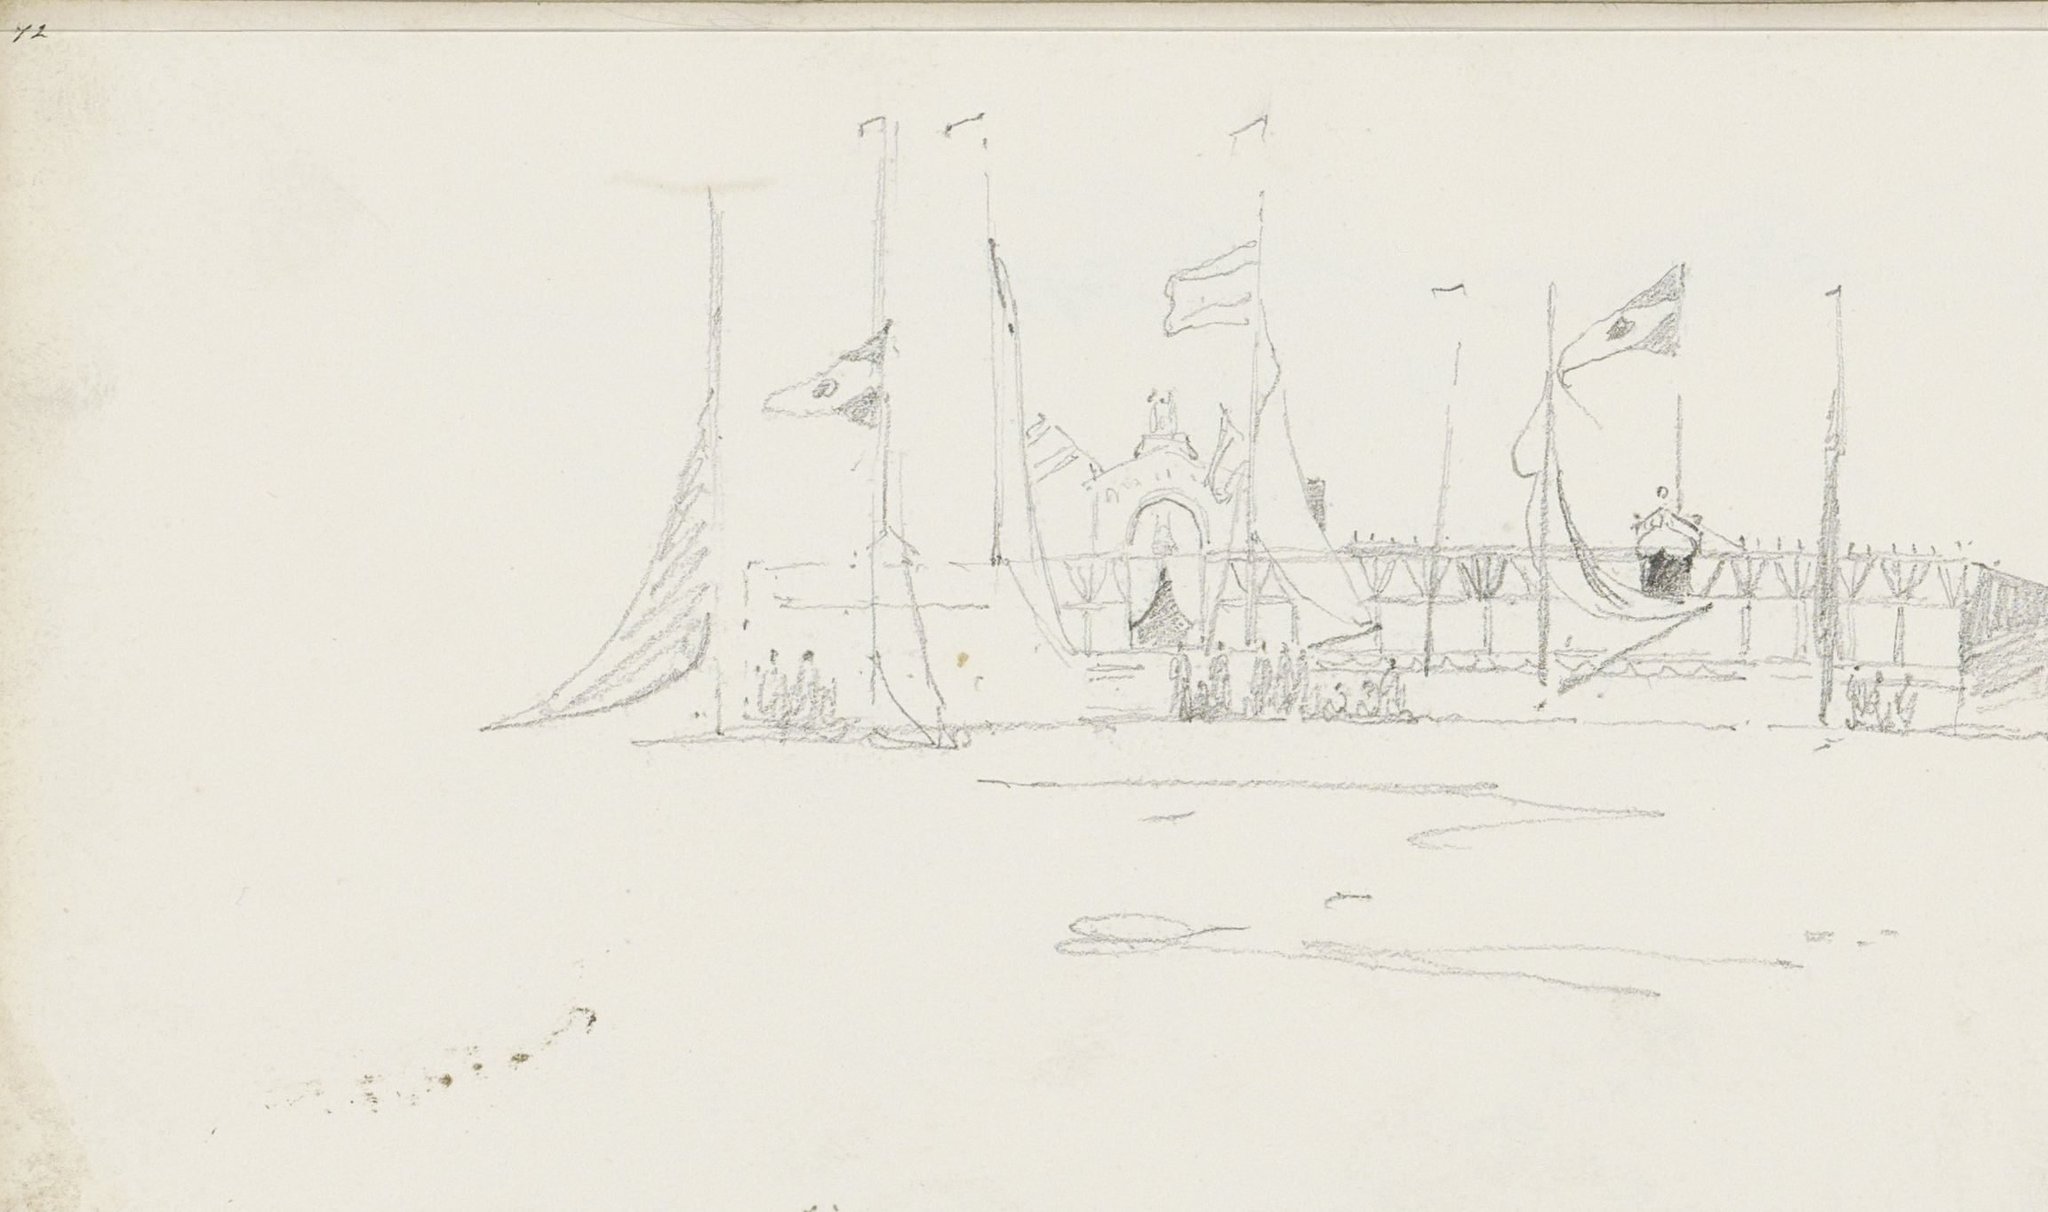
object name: sketchbook leaf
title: Tribune voor een vlootschouw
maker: petrus johannes schotel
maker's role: draughtsman, painter, print maker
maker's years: 1808-1865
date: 1841-1865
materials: paper, pencil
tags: flags flown from a mast, open-air recreation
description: Pagina 72 uit een schetsboek met 80 pagina's.